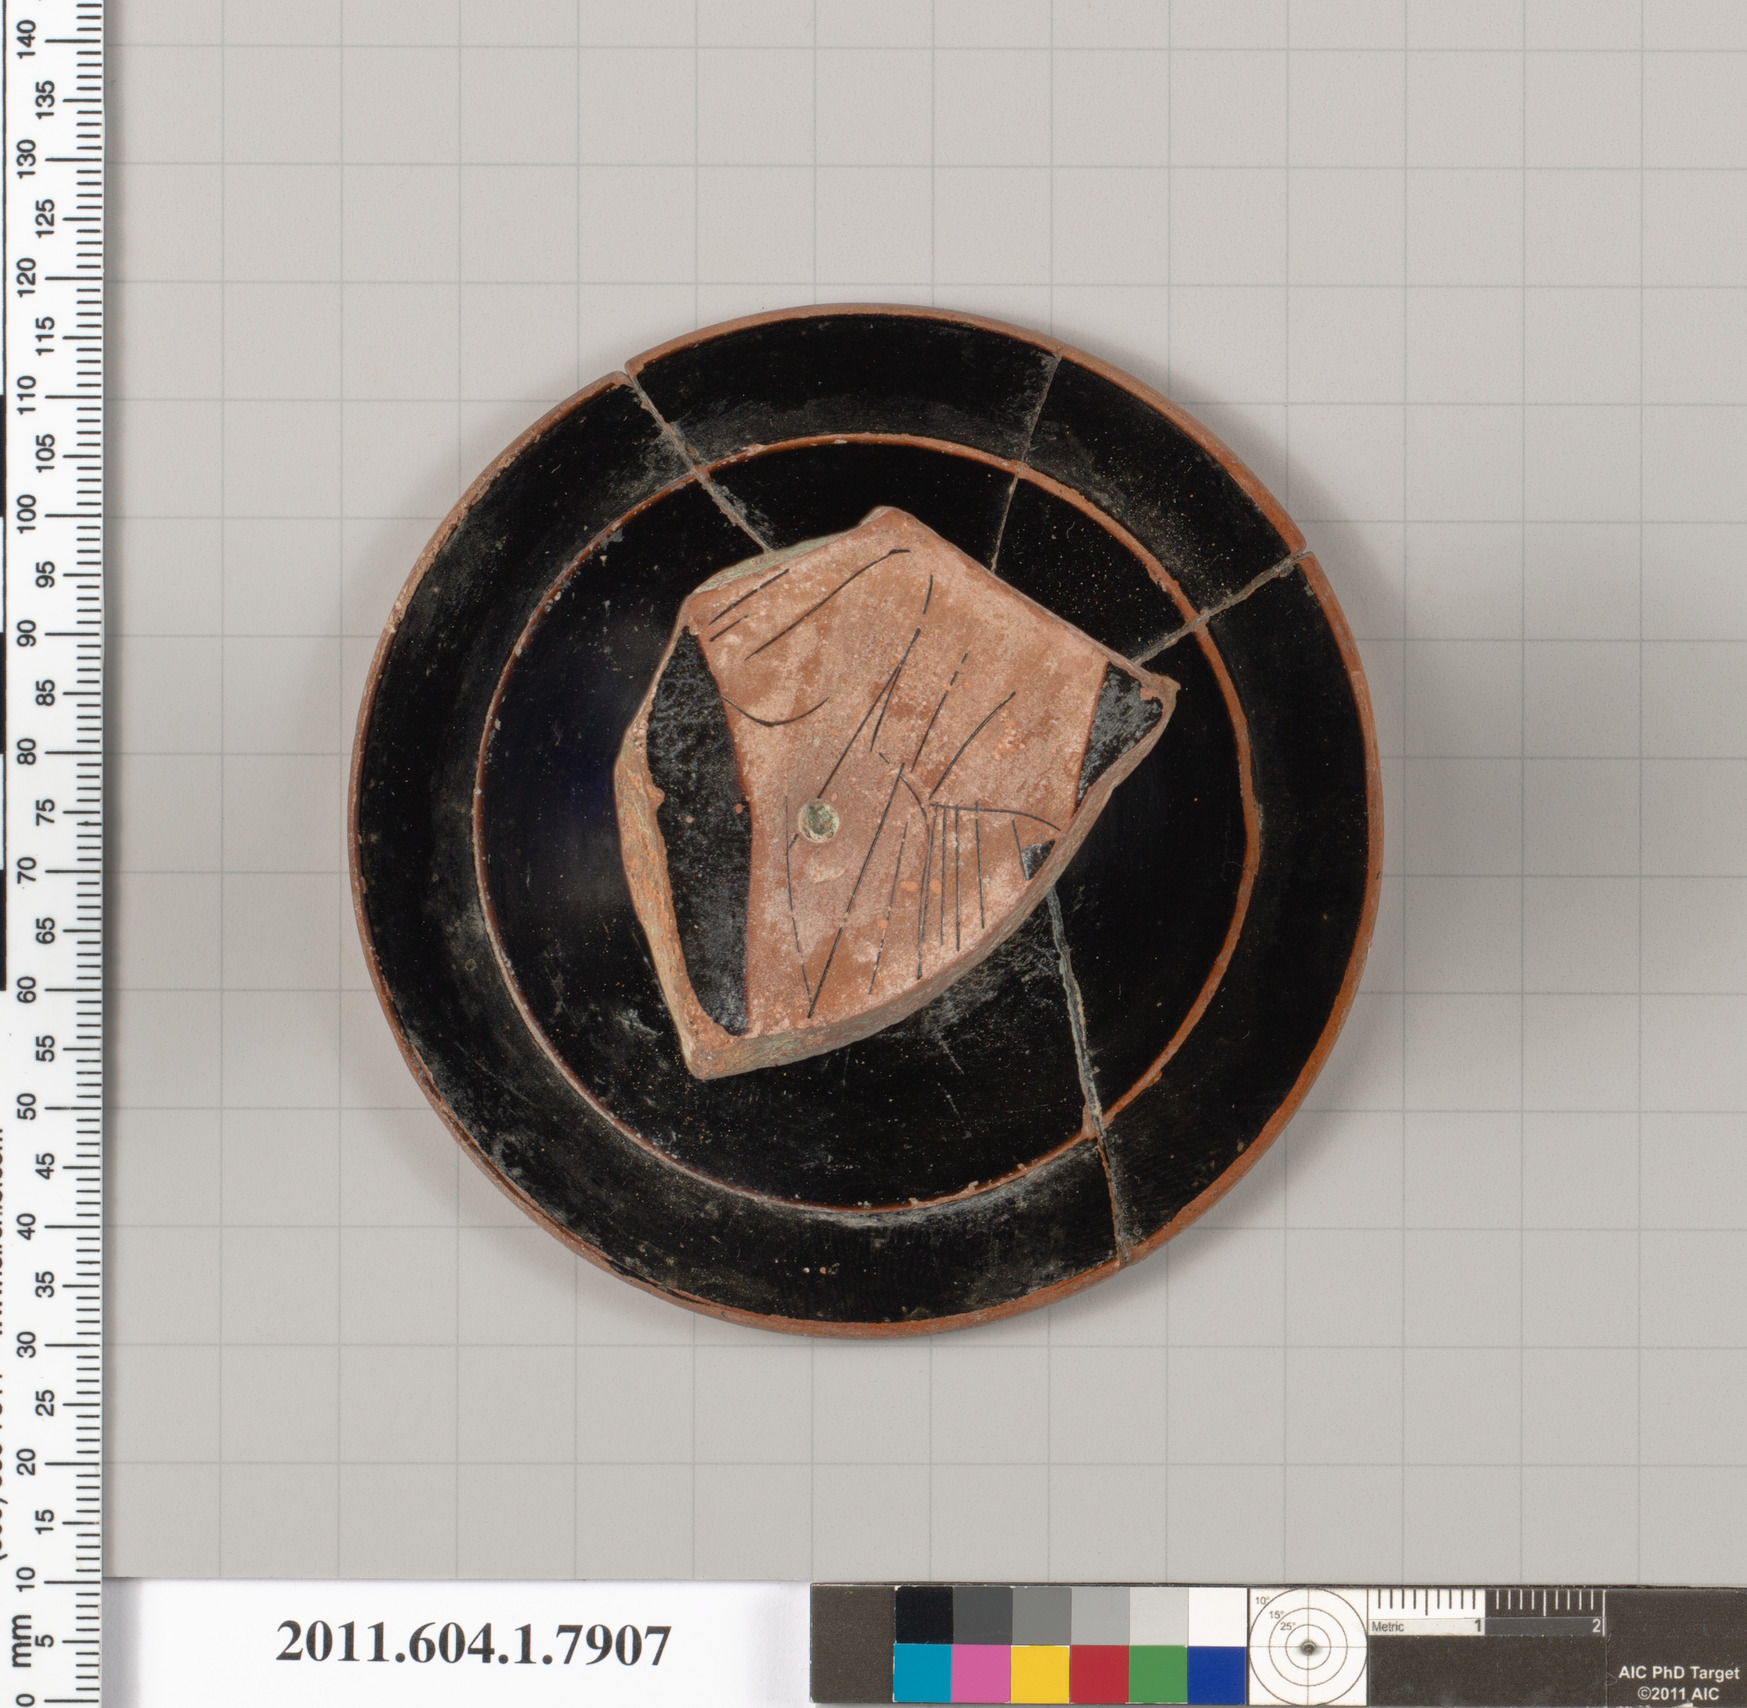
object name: kylix fragment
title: Terracotta fragment of a kylix (drinking cup)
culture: greek, attic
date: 450 BCE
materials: terracotta